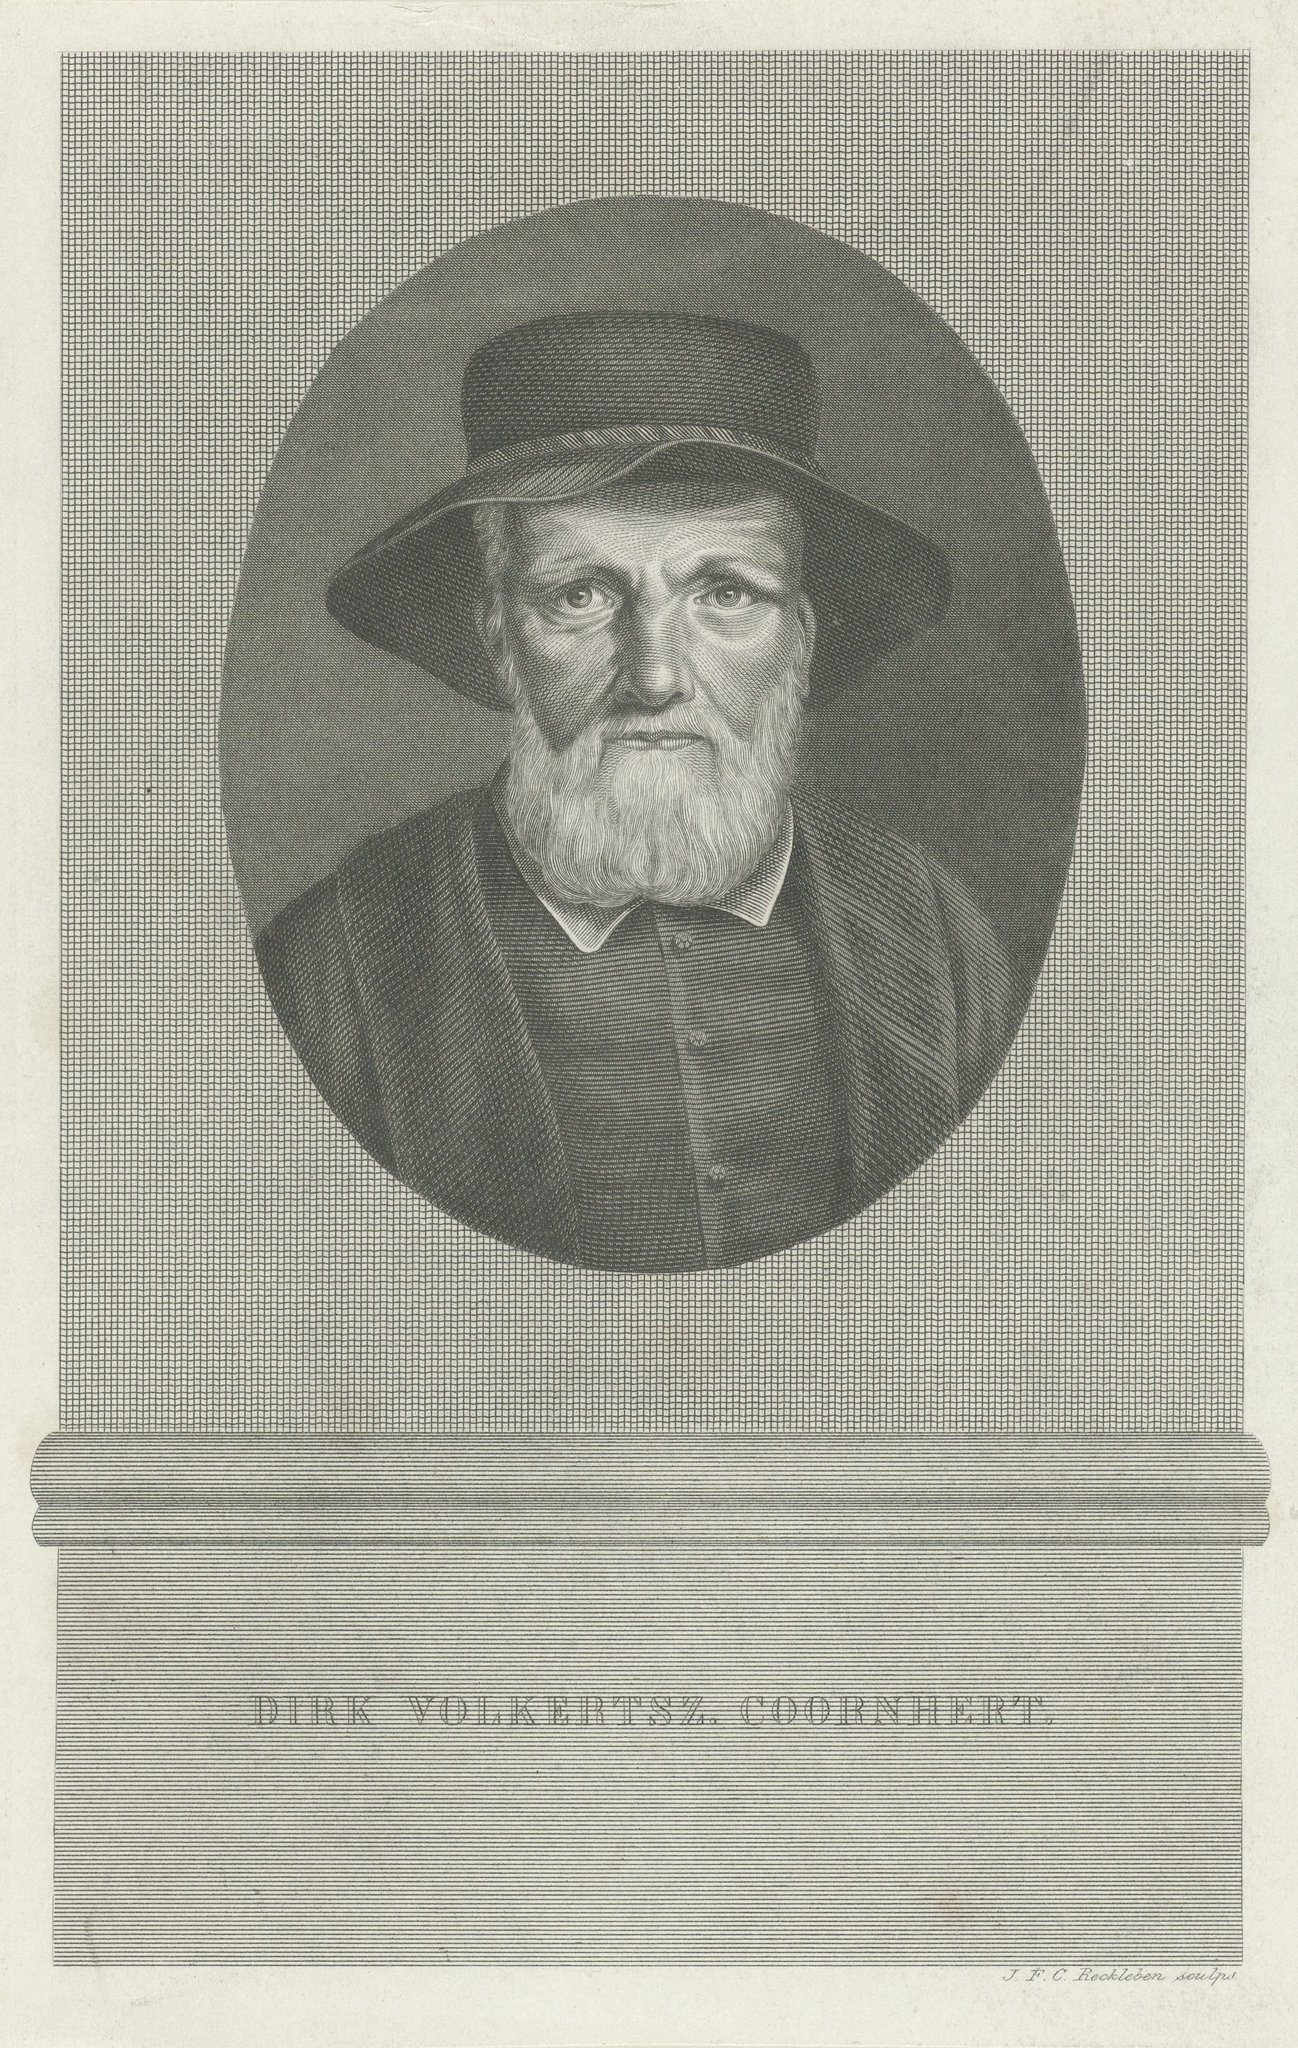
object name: print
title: Portret van Dirk Volkertsz Coornhert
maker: jan frederik christiaan reckleben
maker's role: print maker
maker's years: 1819-1879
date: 1853-1855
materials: paper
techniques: engraving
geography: amsterdam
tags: amsterdam, gouda, print maker, draughtsman, dirck volckertsz. coornhert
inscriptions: collector's mark: Lugt 2228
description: Illustratie in: Arend, Johannes Pieter. Algemeene geschiedenis des vaderlands van de vroegste tijden tot op heden. 5 delen, Amsterdam: Schleijer, J.F. 1840-1884, dl. 3.1, p. 197.